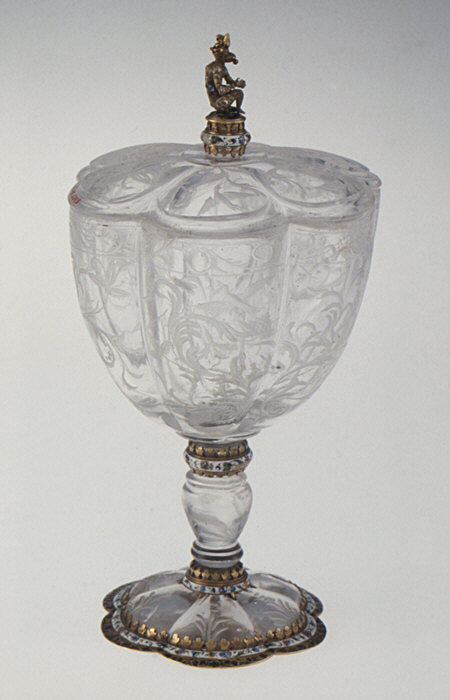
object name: vase with cover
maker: imperial court workshop, prague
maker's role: maker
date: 1634-1666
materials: enamel, gold, quartz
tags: birds